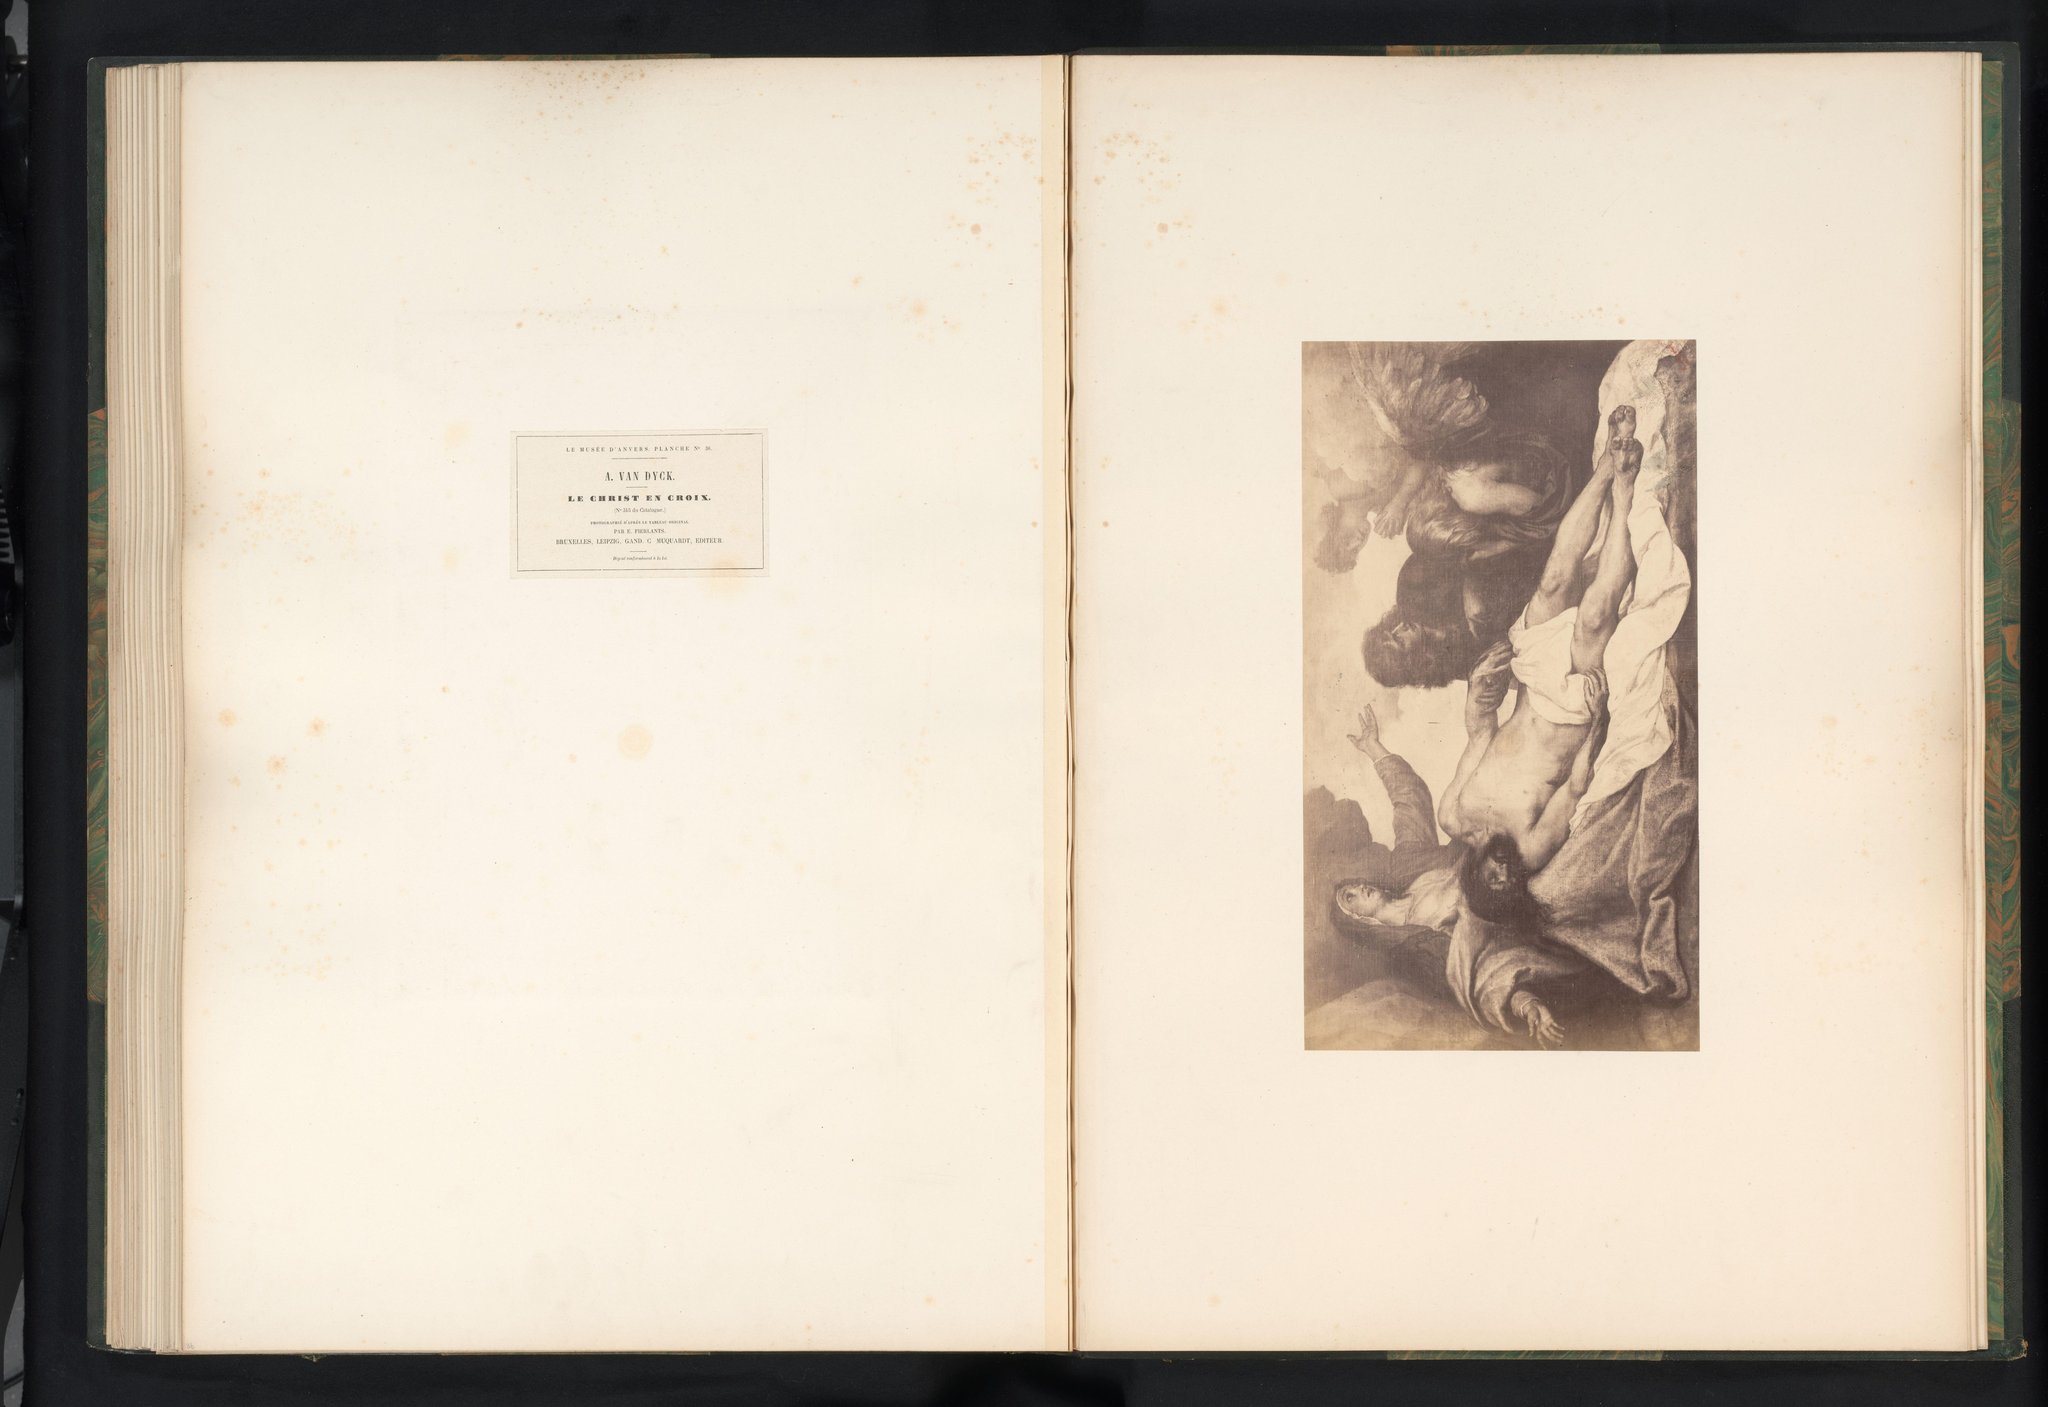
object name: photograph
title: Fotoreproductie van de Bewening van Christus door Anthony van Dyck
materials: photographic support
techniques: albumen print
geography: brussels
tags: christ's body supported by mary, others present